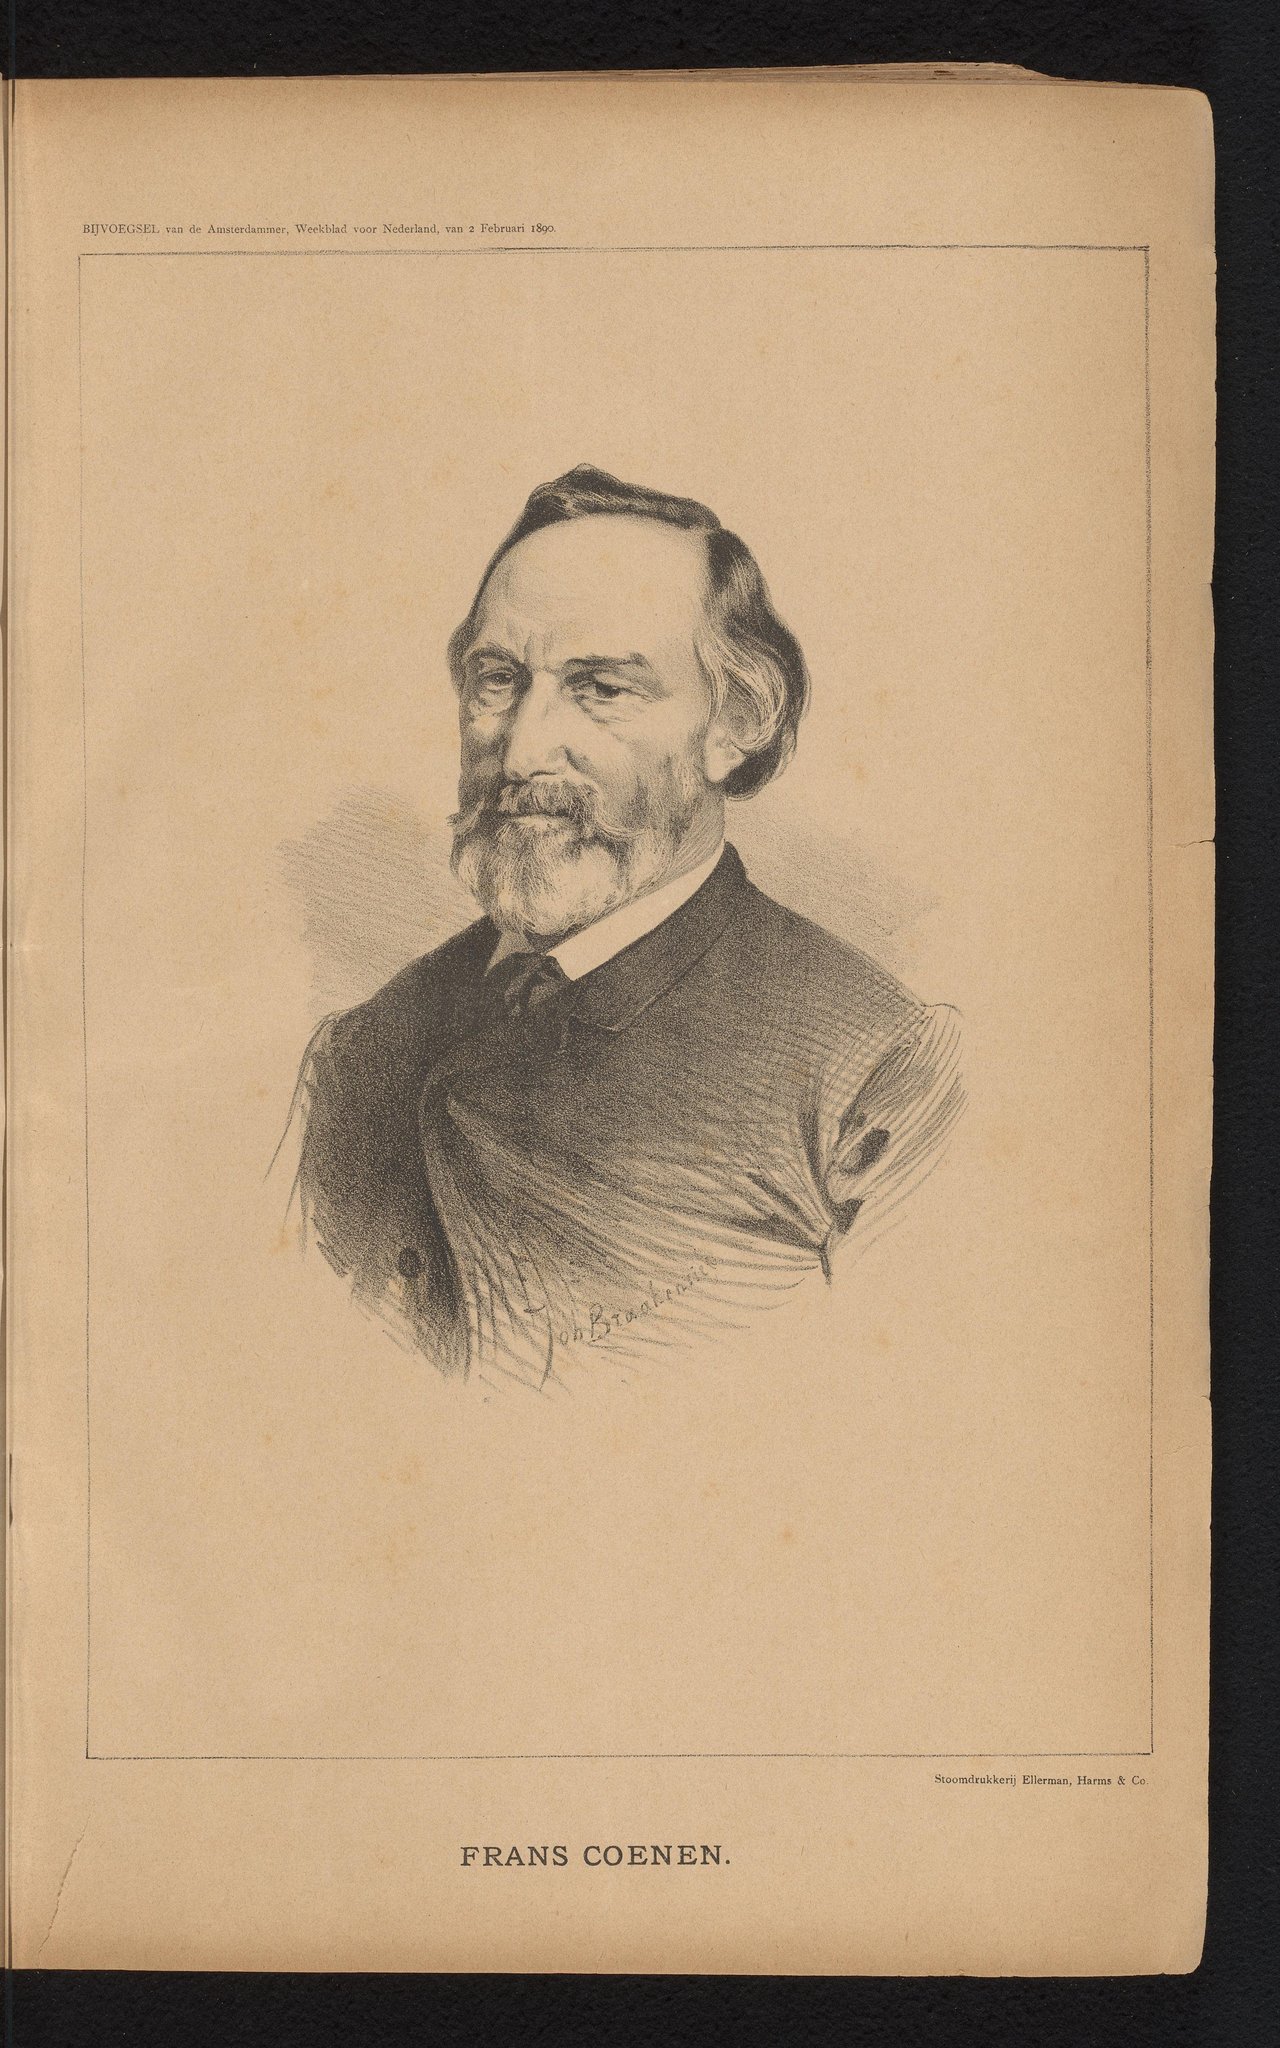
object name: print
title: Frans Coenen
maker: johan braakensiek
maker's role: draughtsman, print maker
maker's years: 1858-1940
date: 1890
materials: paper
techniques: lithograph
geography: amsterdam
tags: rotterdam, leiden, historical persons, portrait of composer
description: Gepubliceerd als bijvoegsel bij 'De Amsterdammer', 2 februari 1890.